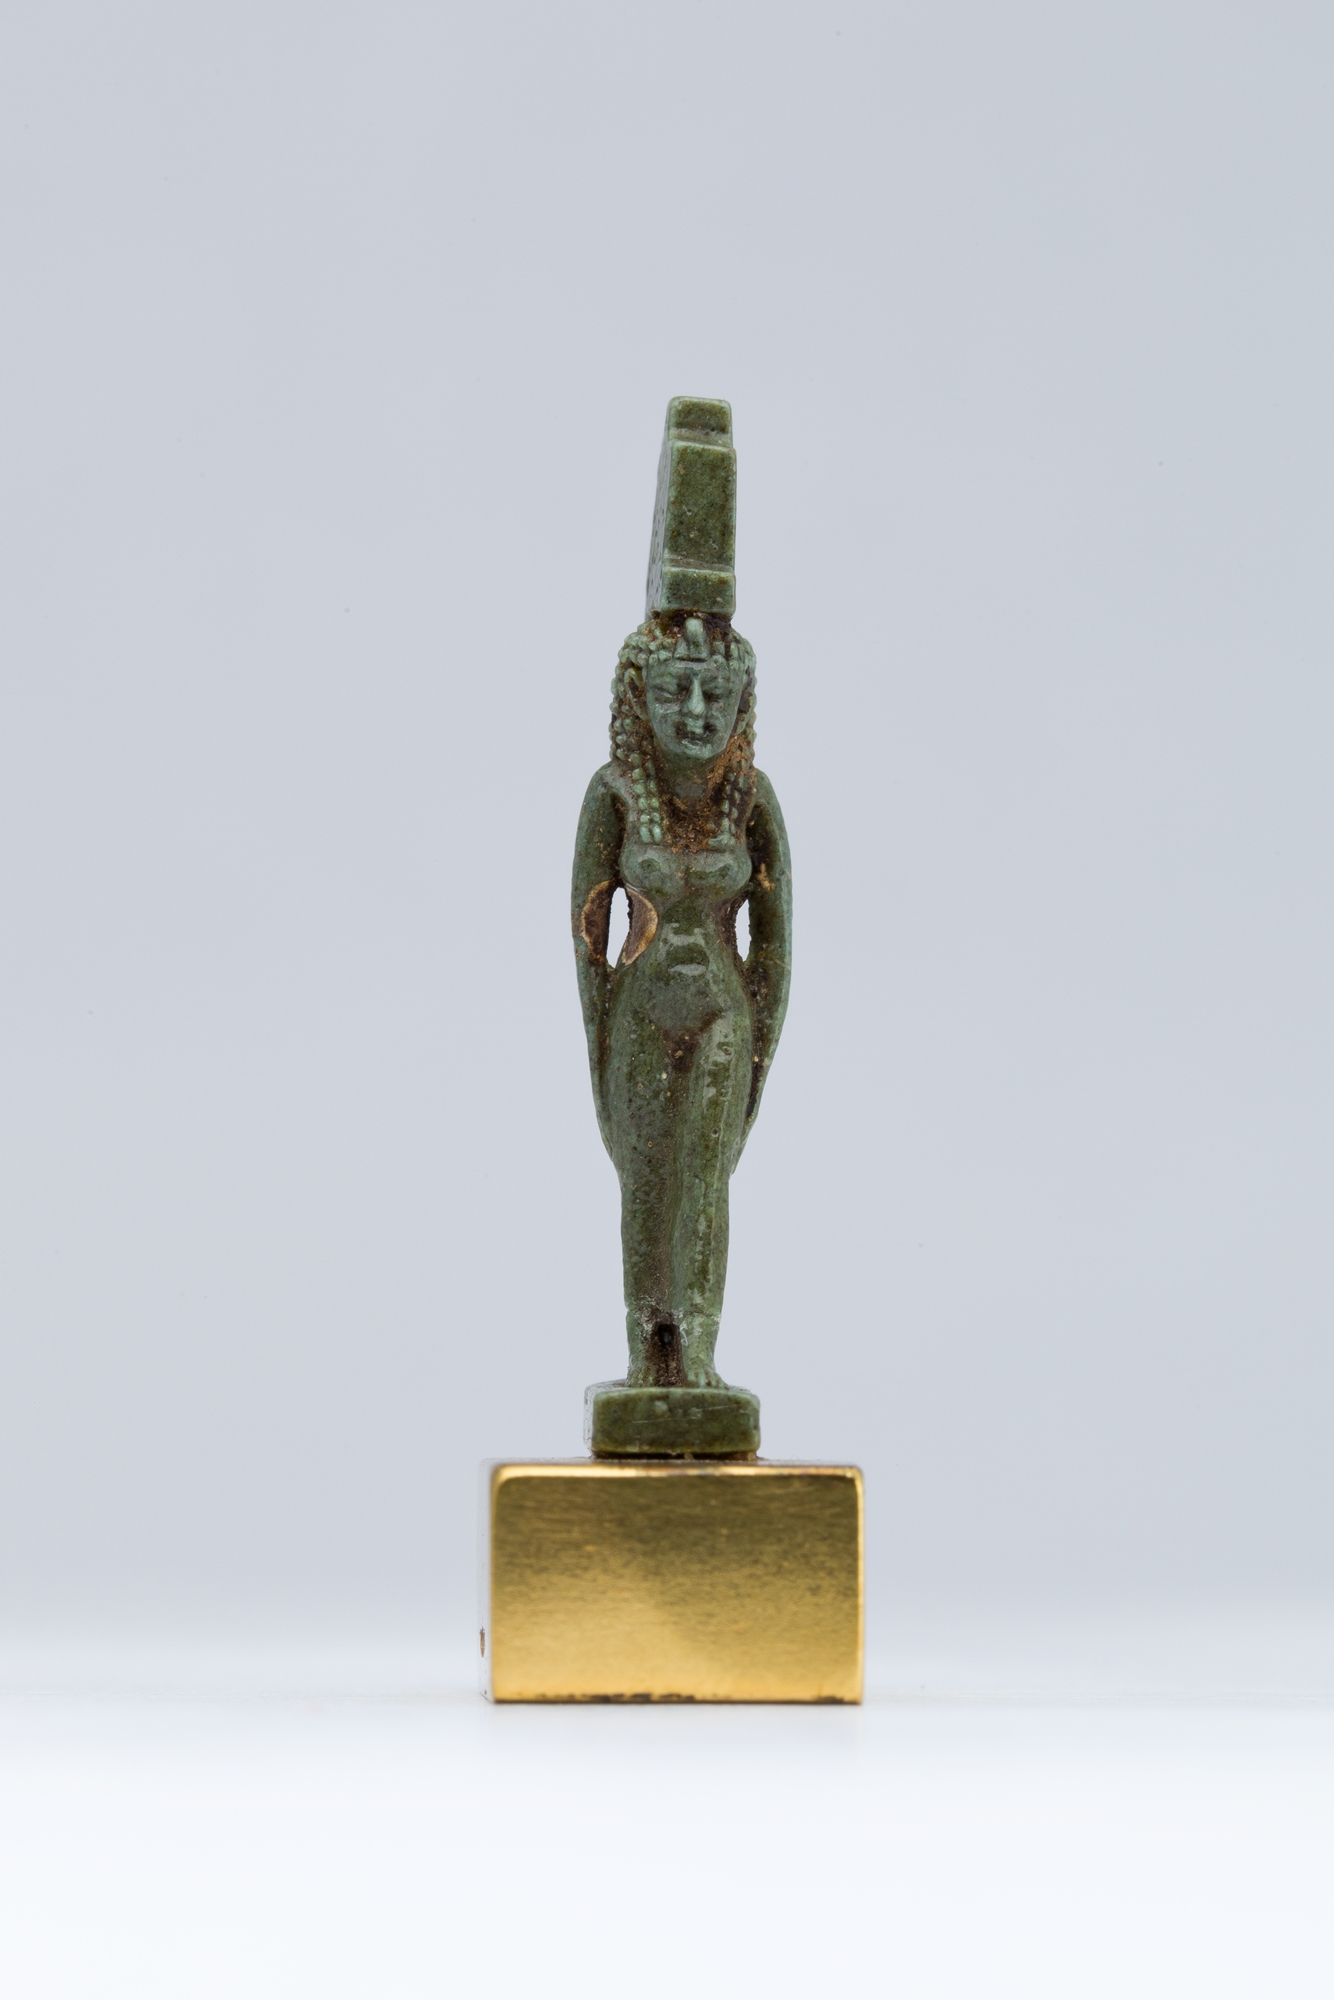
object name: amulet, isi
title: Isis amulet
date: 332-330 BCE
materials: faience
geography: egypt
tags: isis